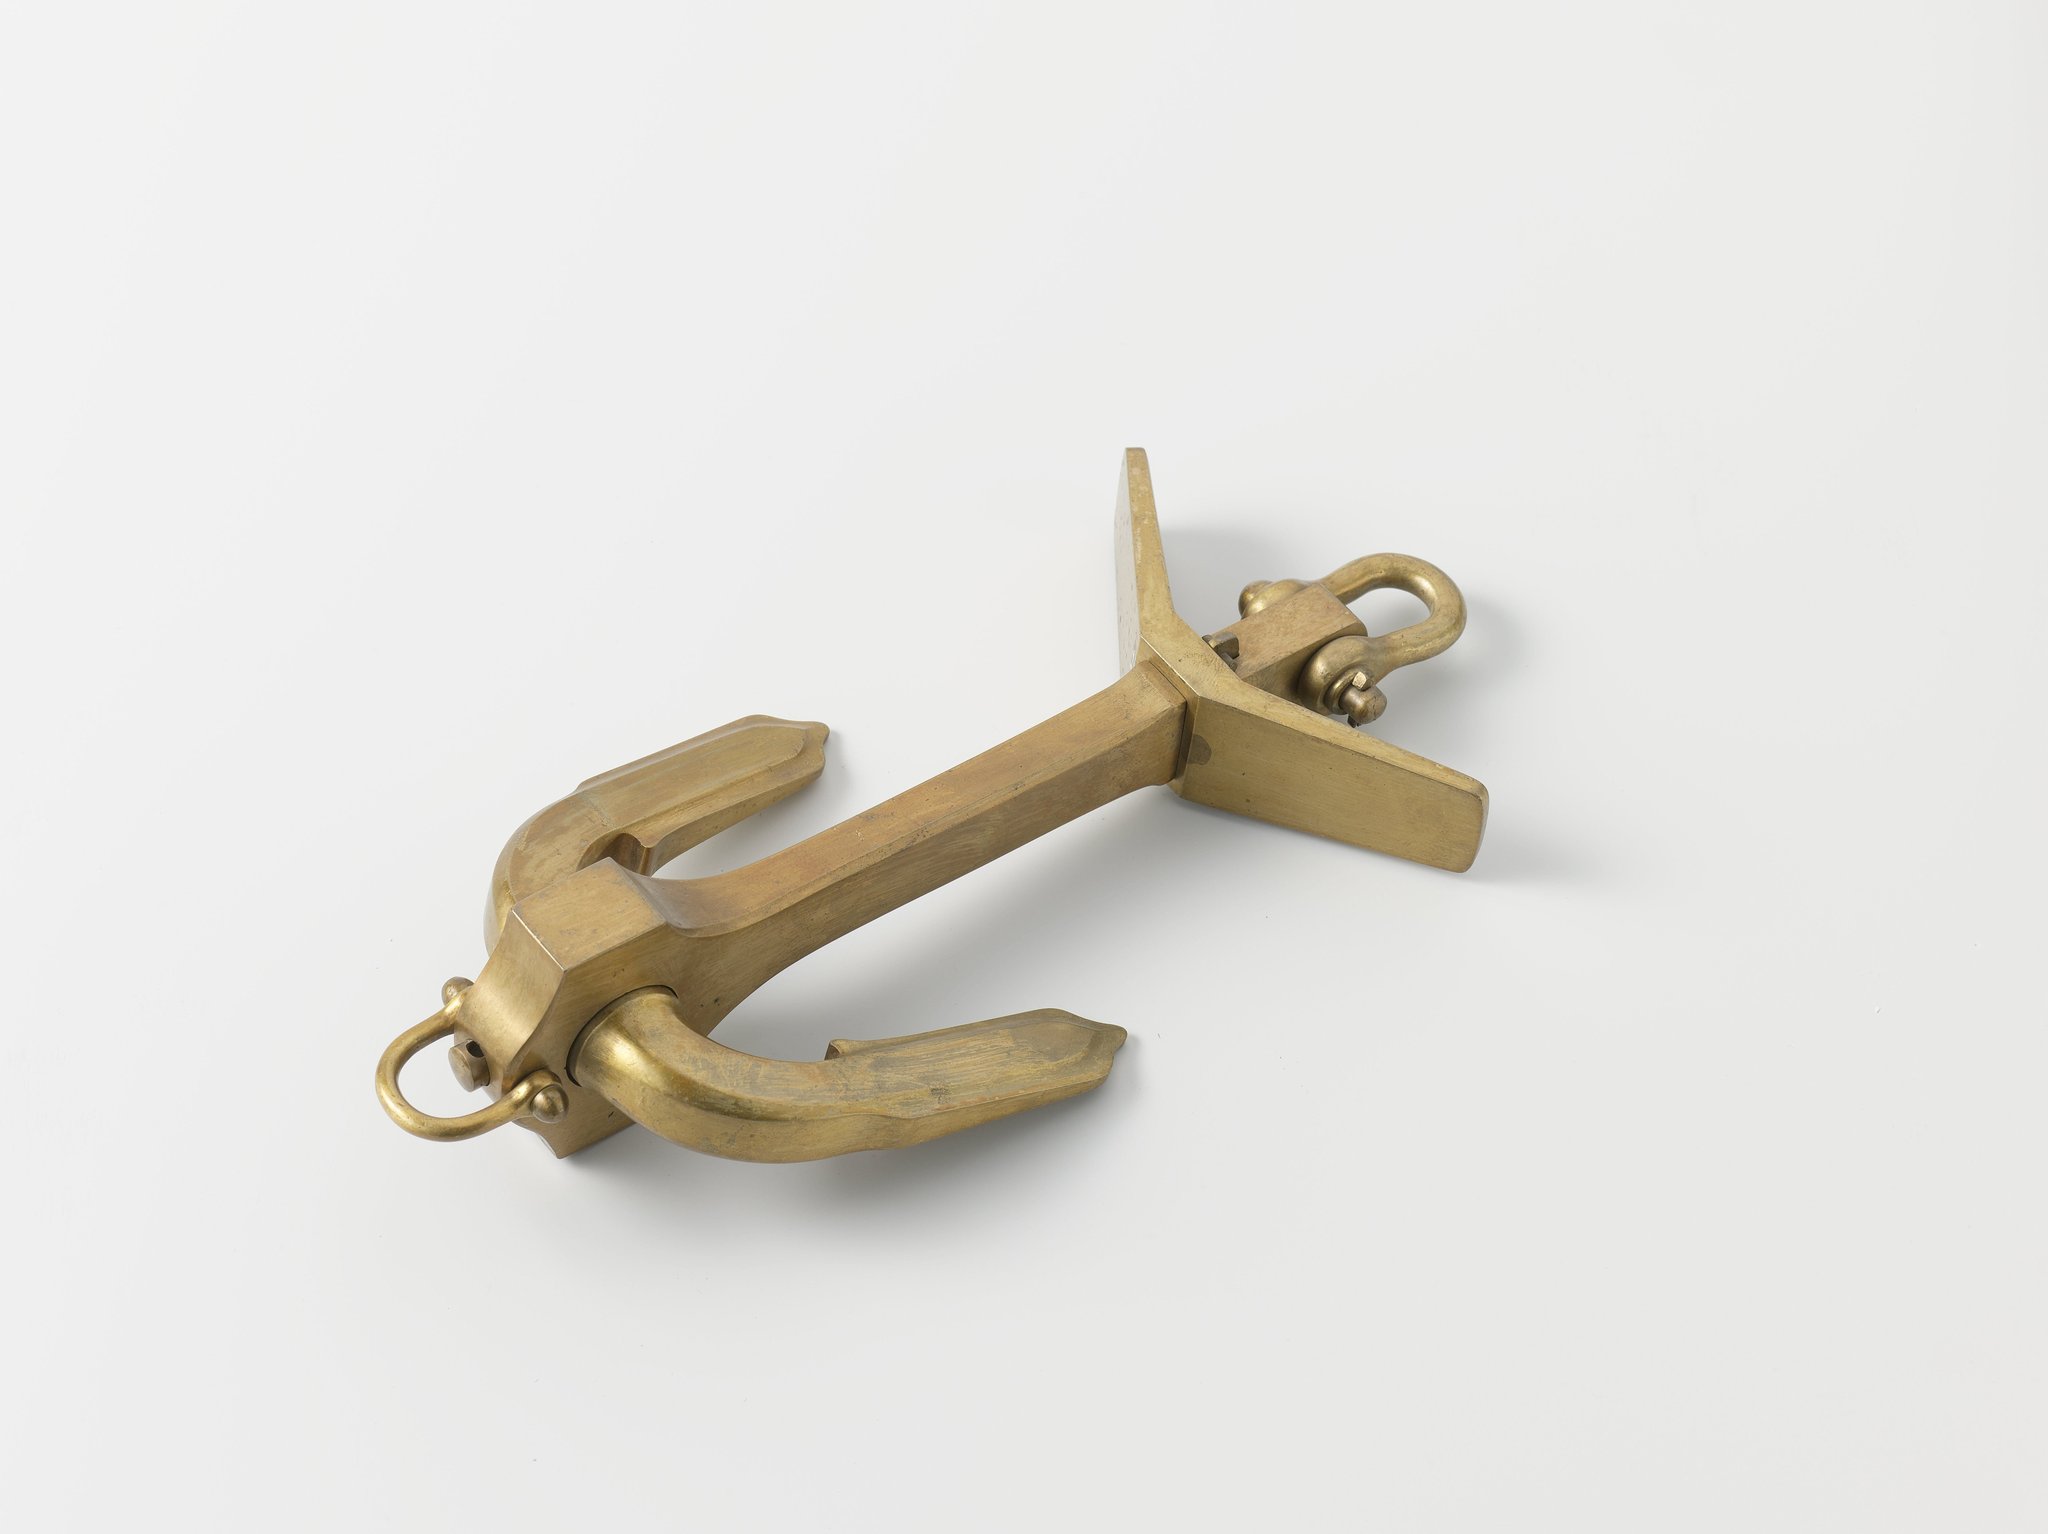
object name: instruction model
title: Model of an Anchor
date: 1880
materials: brass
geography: marseille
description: De gegevens omtrent de vervaardiging van het model zijn tegenstrijdig. In 1869 bestond er een model, dat door de Grofsmederij Leiden werd gebruikt bij de fabricage van een aantal ankers. Volgens de toenmalige opzichter van de modellenkamer J.J. Backer Dirks echter, werd het model op de Rijkswerf te Amsterdam vervaardigd in 1880; de archiefstukken waarnaar hij verwijst zijn echter niet achterhaald. Hoewel de tien ankers die de Grofsmederij Leiden in 1869 naar dit ontwerp leverde wat gewicht betreft nogal afweken van de specificaties, werd de minister toch geadviseerd ze te accepteren. Ze werden naar de Rijkswerf te Amsterdam overgebracht.